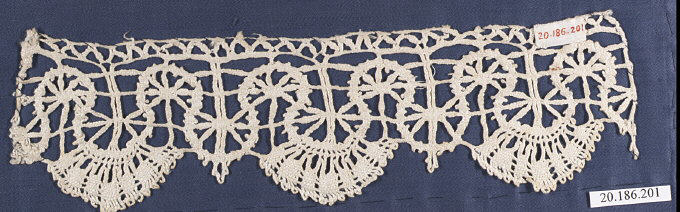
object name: edging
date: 1601-1700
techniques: lace